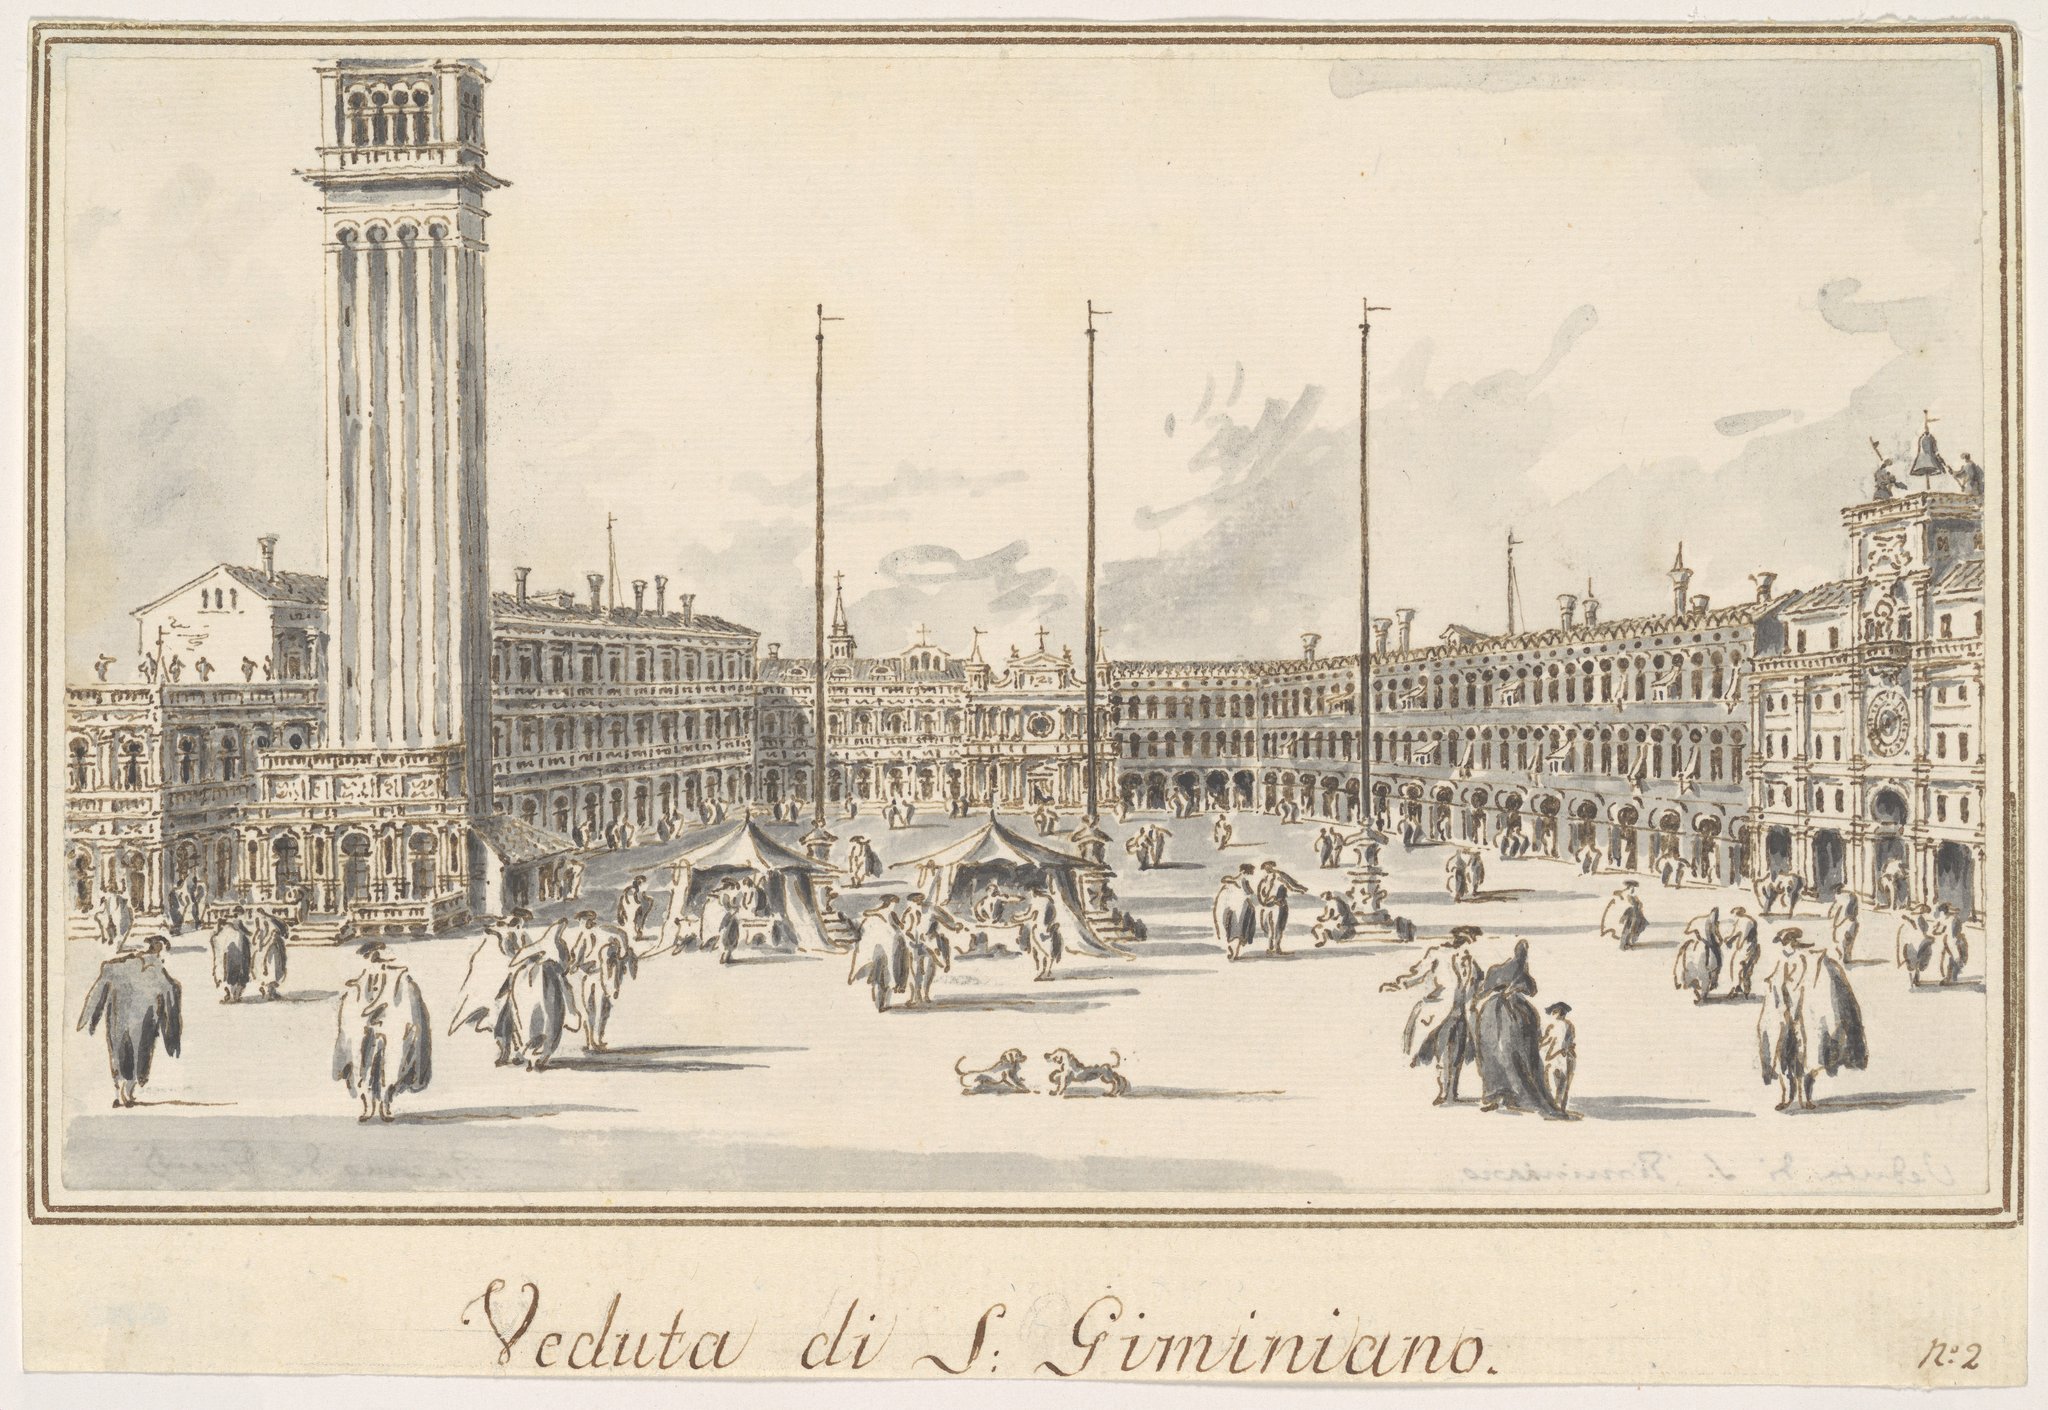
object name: drawing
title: Piazza San Marco, Looking toward the Church of San Gemignano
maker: giacomo guardi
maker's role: artist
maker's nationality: italian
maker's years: 1764-1835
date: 1804-1828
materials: ink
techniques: pen, wash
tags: buildings,towers,cities,venice